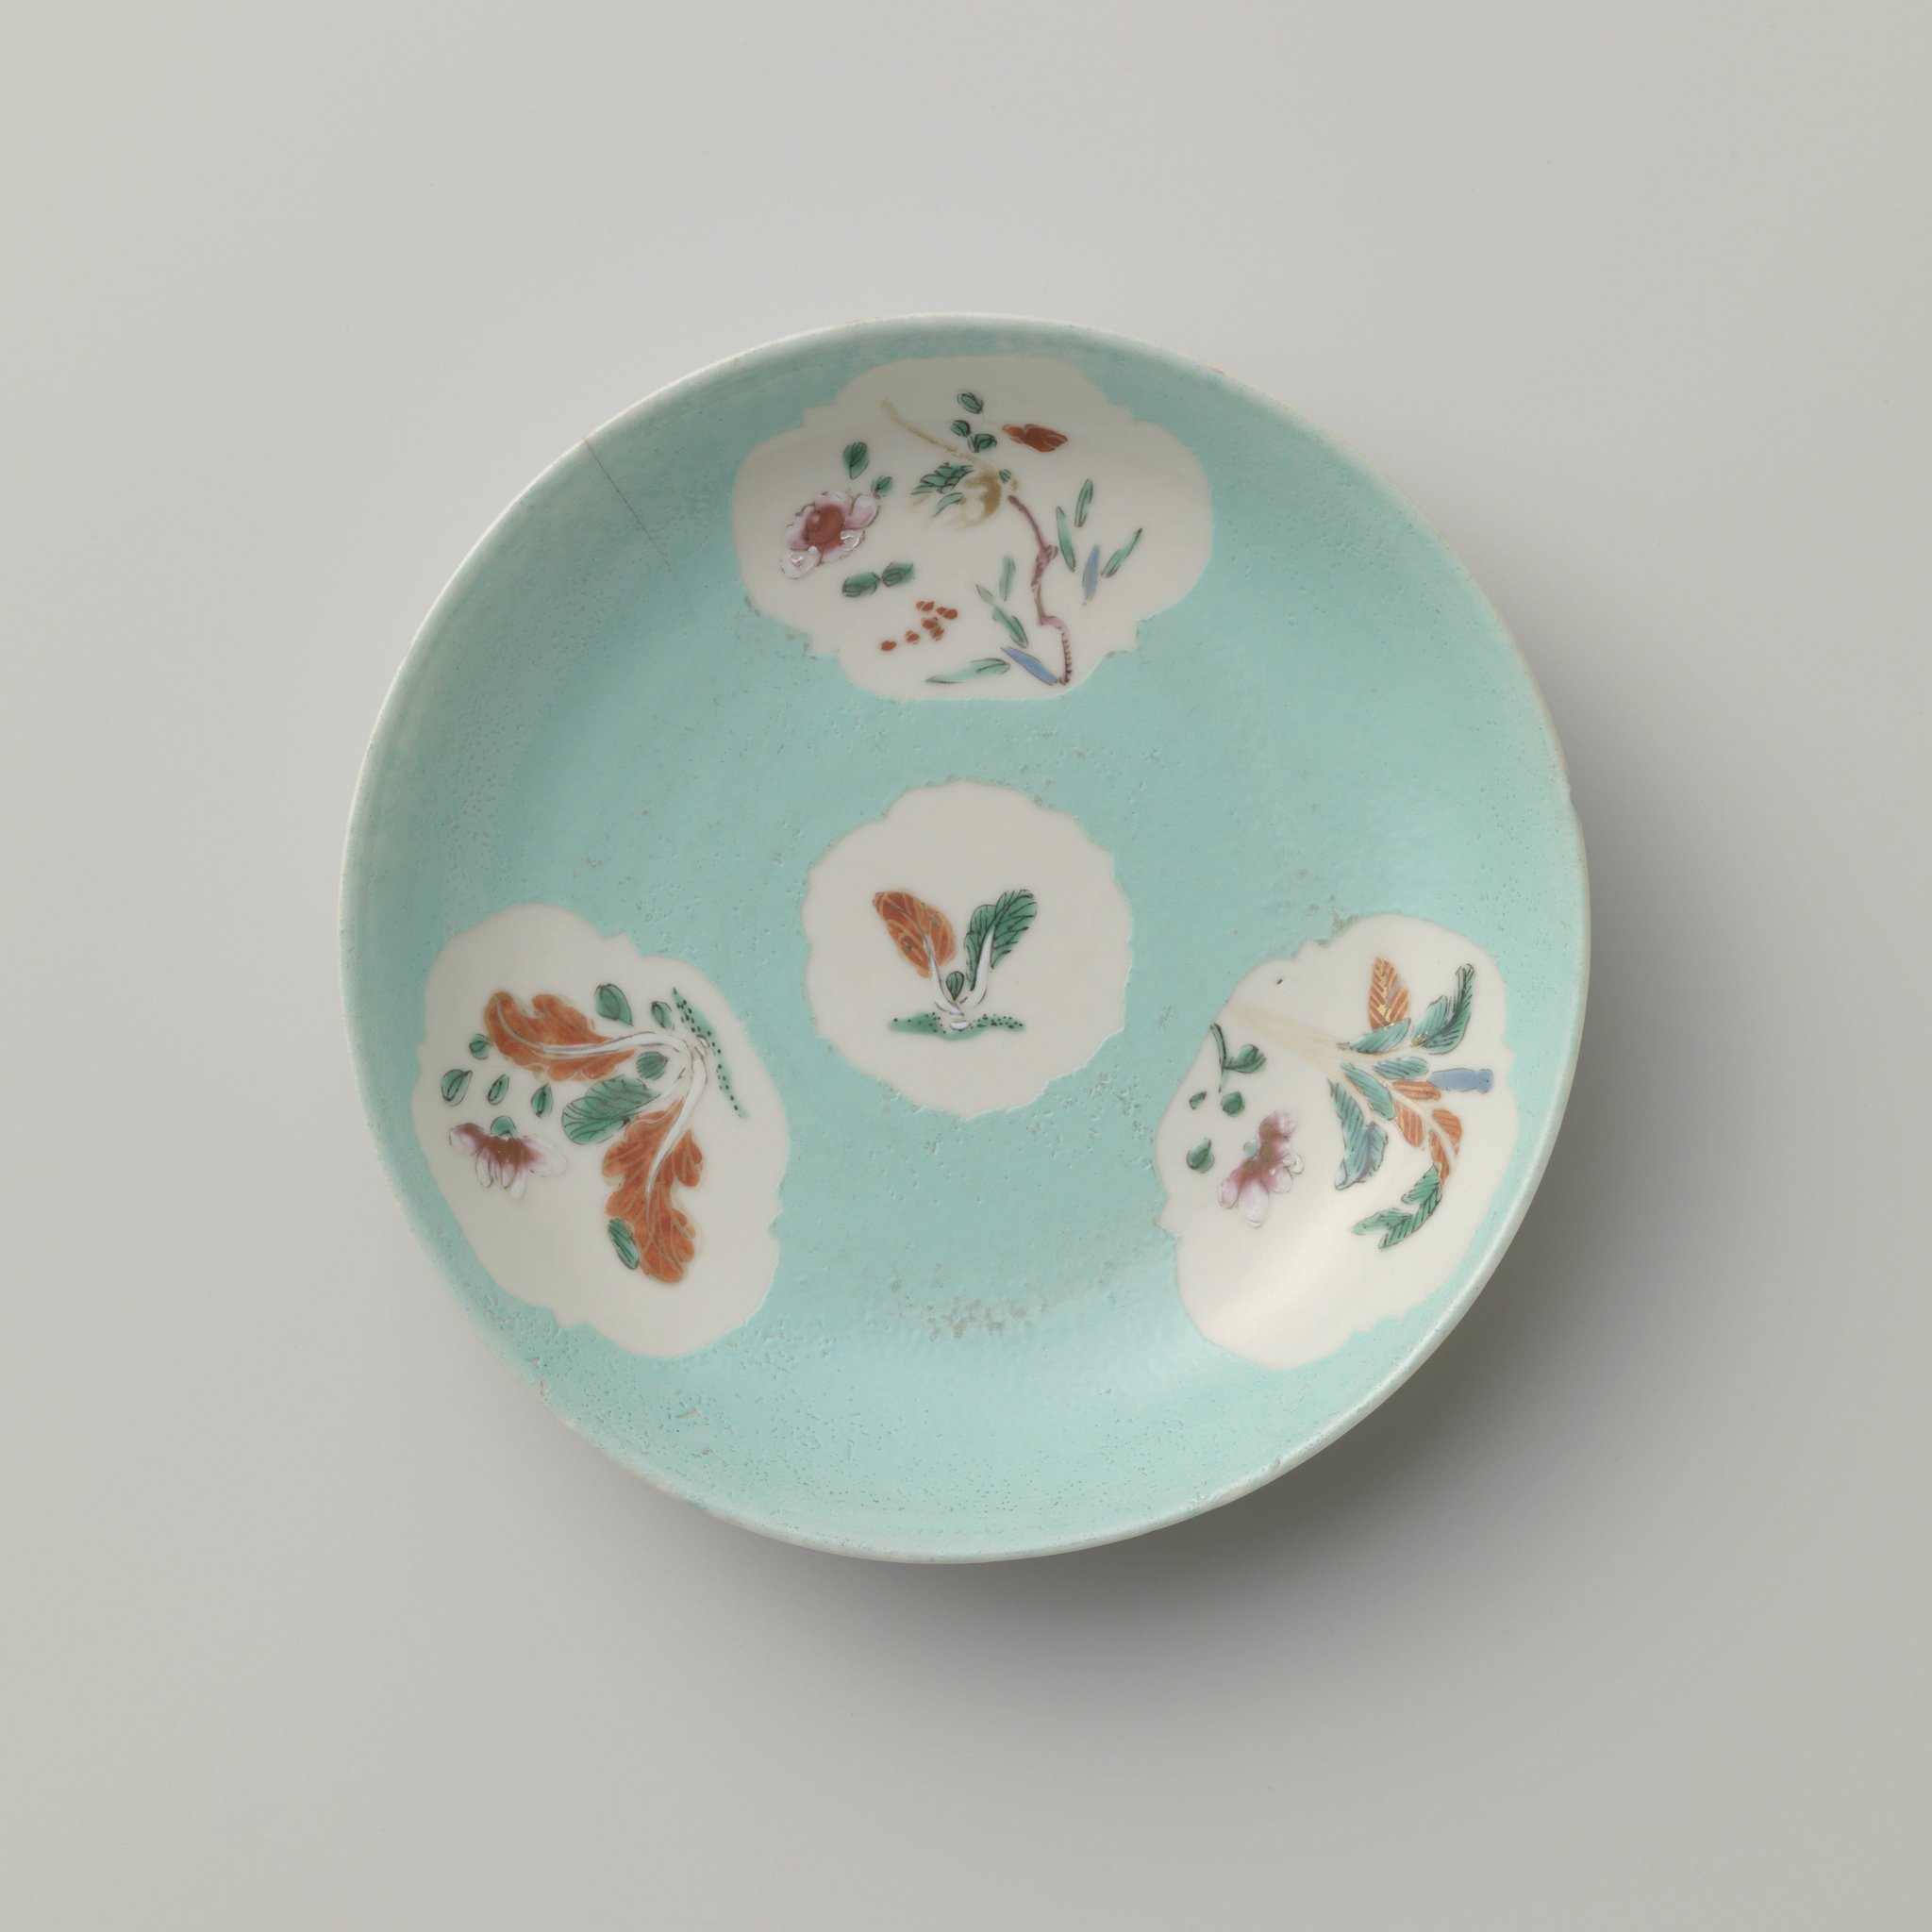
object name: kop en schotel, kop en schotel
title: Saucer with flowering plants in shaped panels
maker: Anonymous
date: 1760-1780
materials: glaze, gold, paint, porcelain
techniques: firing, gilding, turning, vitrification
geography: china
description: Schotel van porselein, bedekt met een turquoise glazuur en berschilderd in blauw, rood, roze, groen, zwart en goud. De schotel is aan de voorzijde bedekt met een turquoise glazuur met hierin uitgespaard in het centrum een geschulpt medaillon met plant, daaromheen drie uitgespaarde cartouches met bloeiende planten en een vogel op een tak. Een barst en een chip in de schotel. Famille rose.